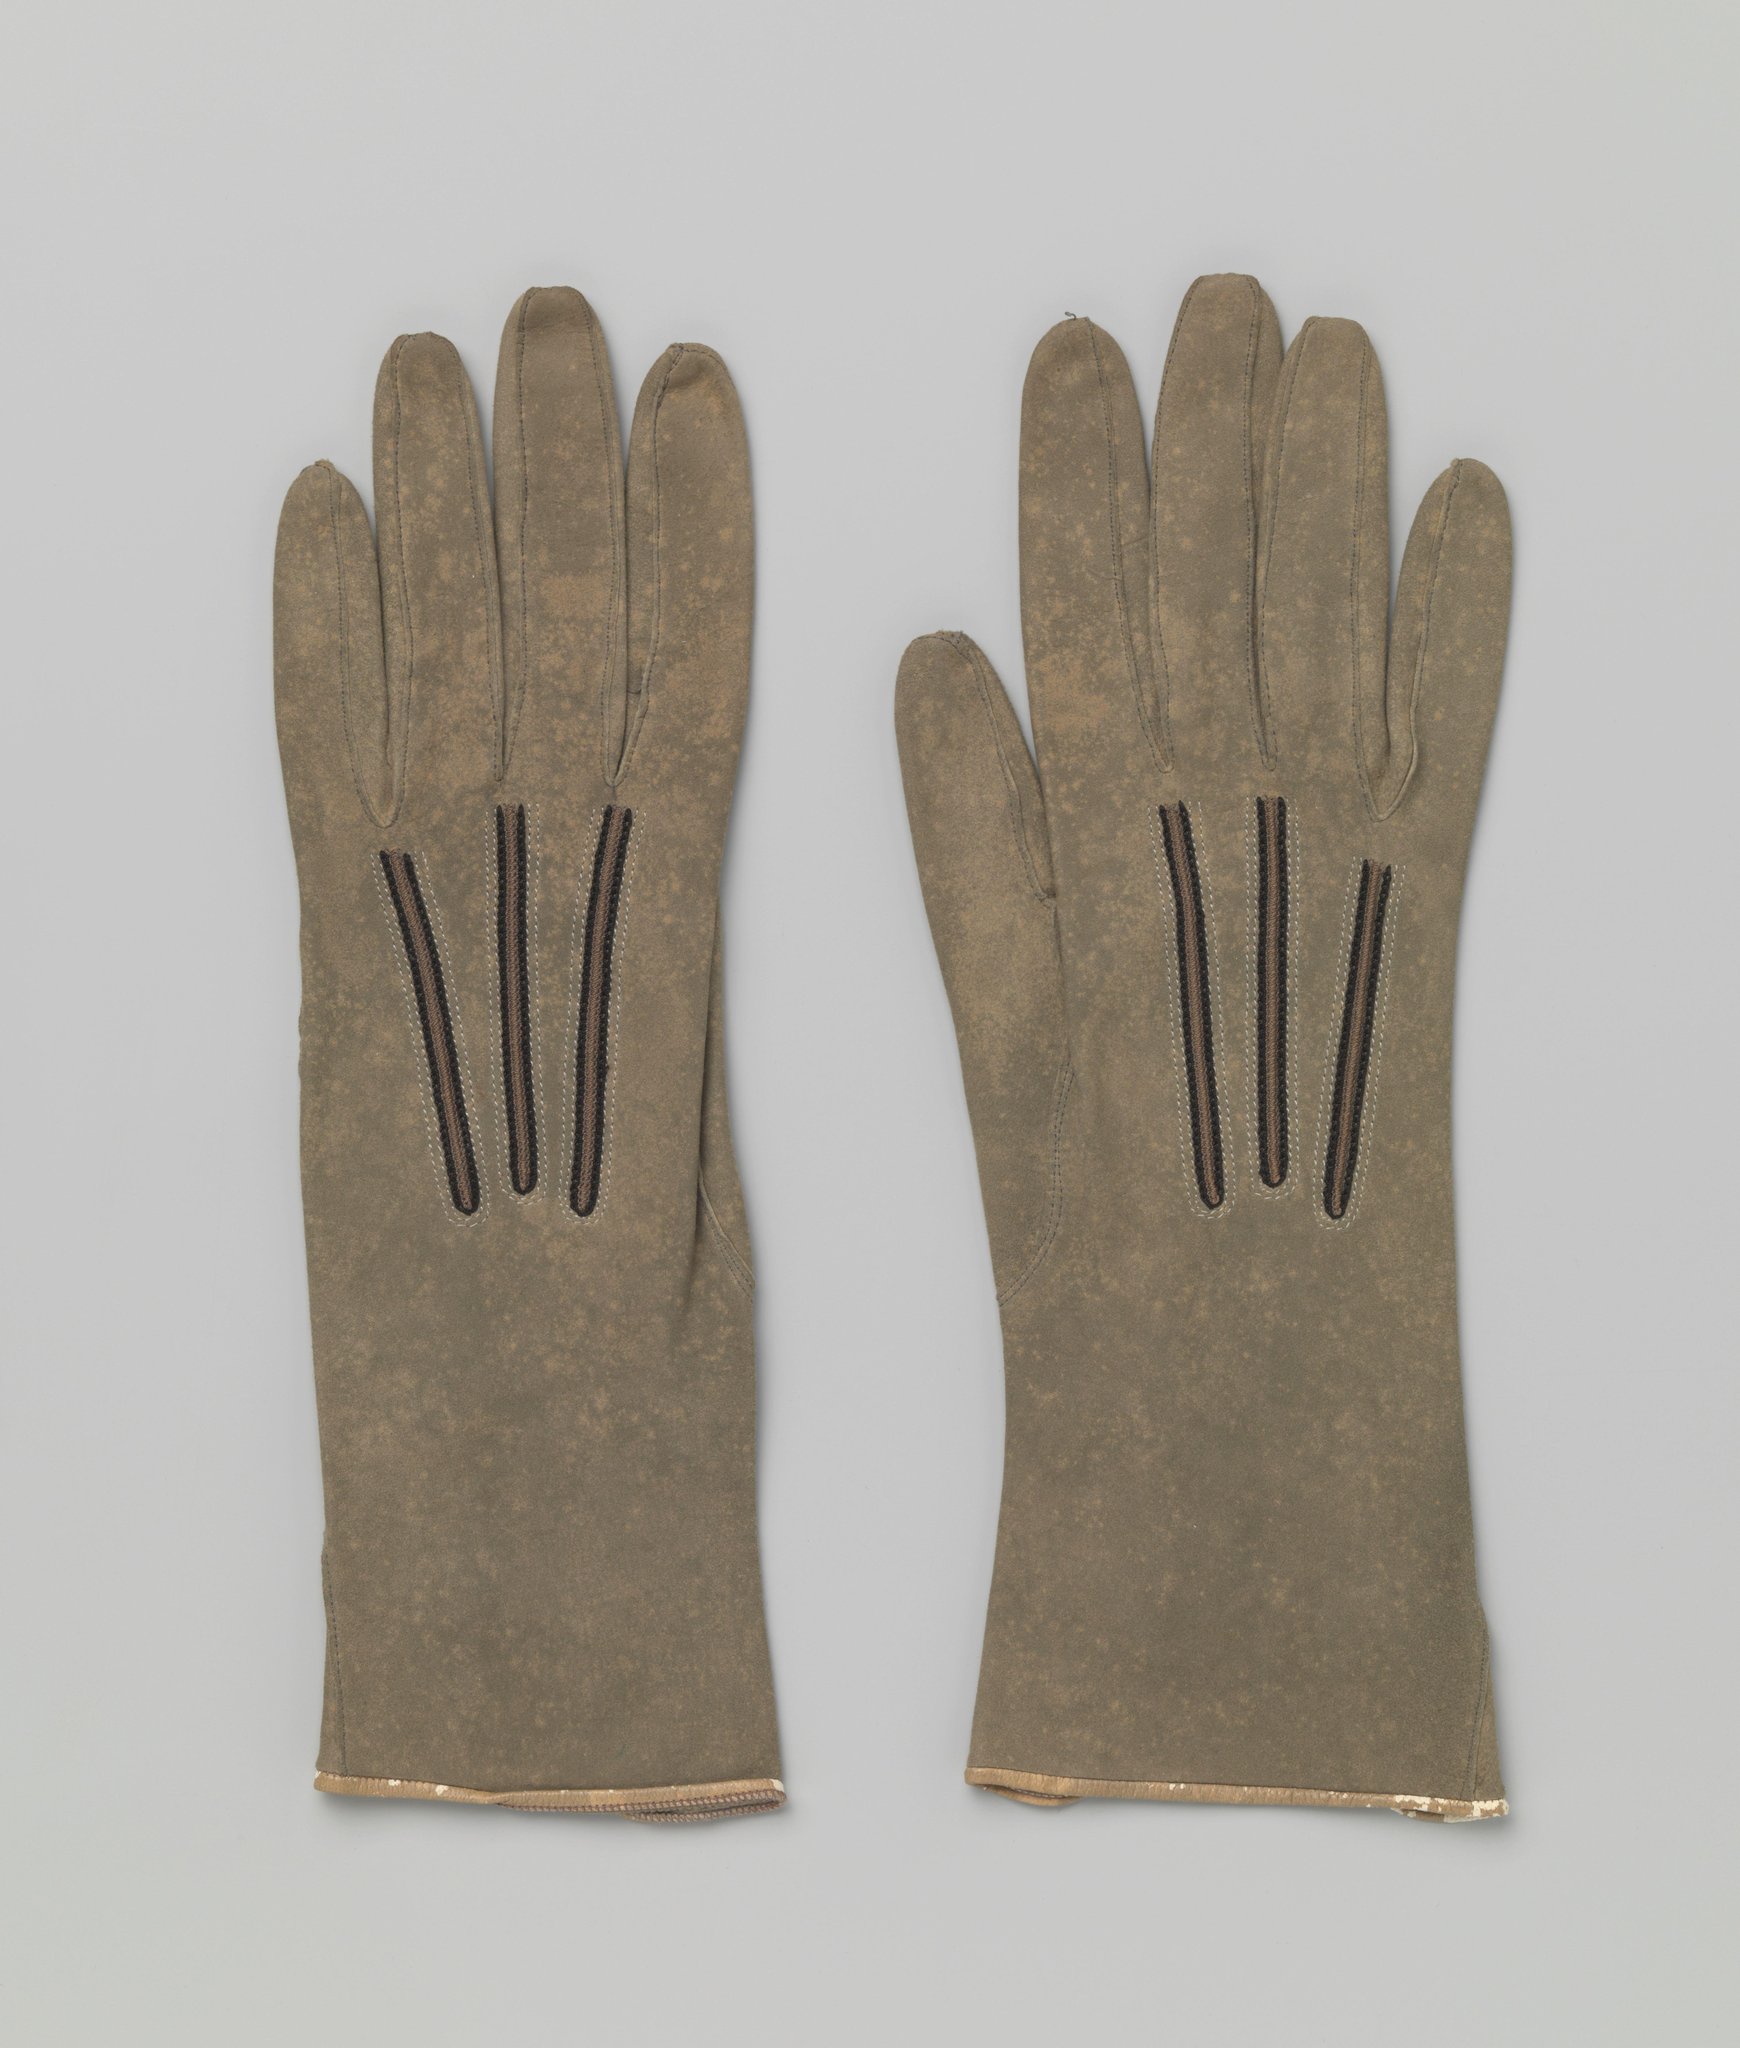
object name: womenswear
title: Linkerhandschoen van groen gevlekte suède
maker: Anonymous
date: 1910-1925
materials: leather, mother of pearl, silk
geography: netherlands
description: Paar korte handschoenen van broen/beige gevlekt suède. Sluiting met drukknopen. Op de hand drie banden bestaande uit bruin/zwart en wit stiksel. Langs de manchet en sluiting zijn de handschoenen afgezet met een smalle, dubbelgevouwen rand beige leer. Adres (in de linkerhandschoen de stempels): GANT PERRIN / EXTRA SUèDE / 302 BIS, (in de rechterhandschoen: 6 3/4 DEPOSE.